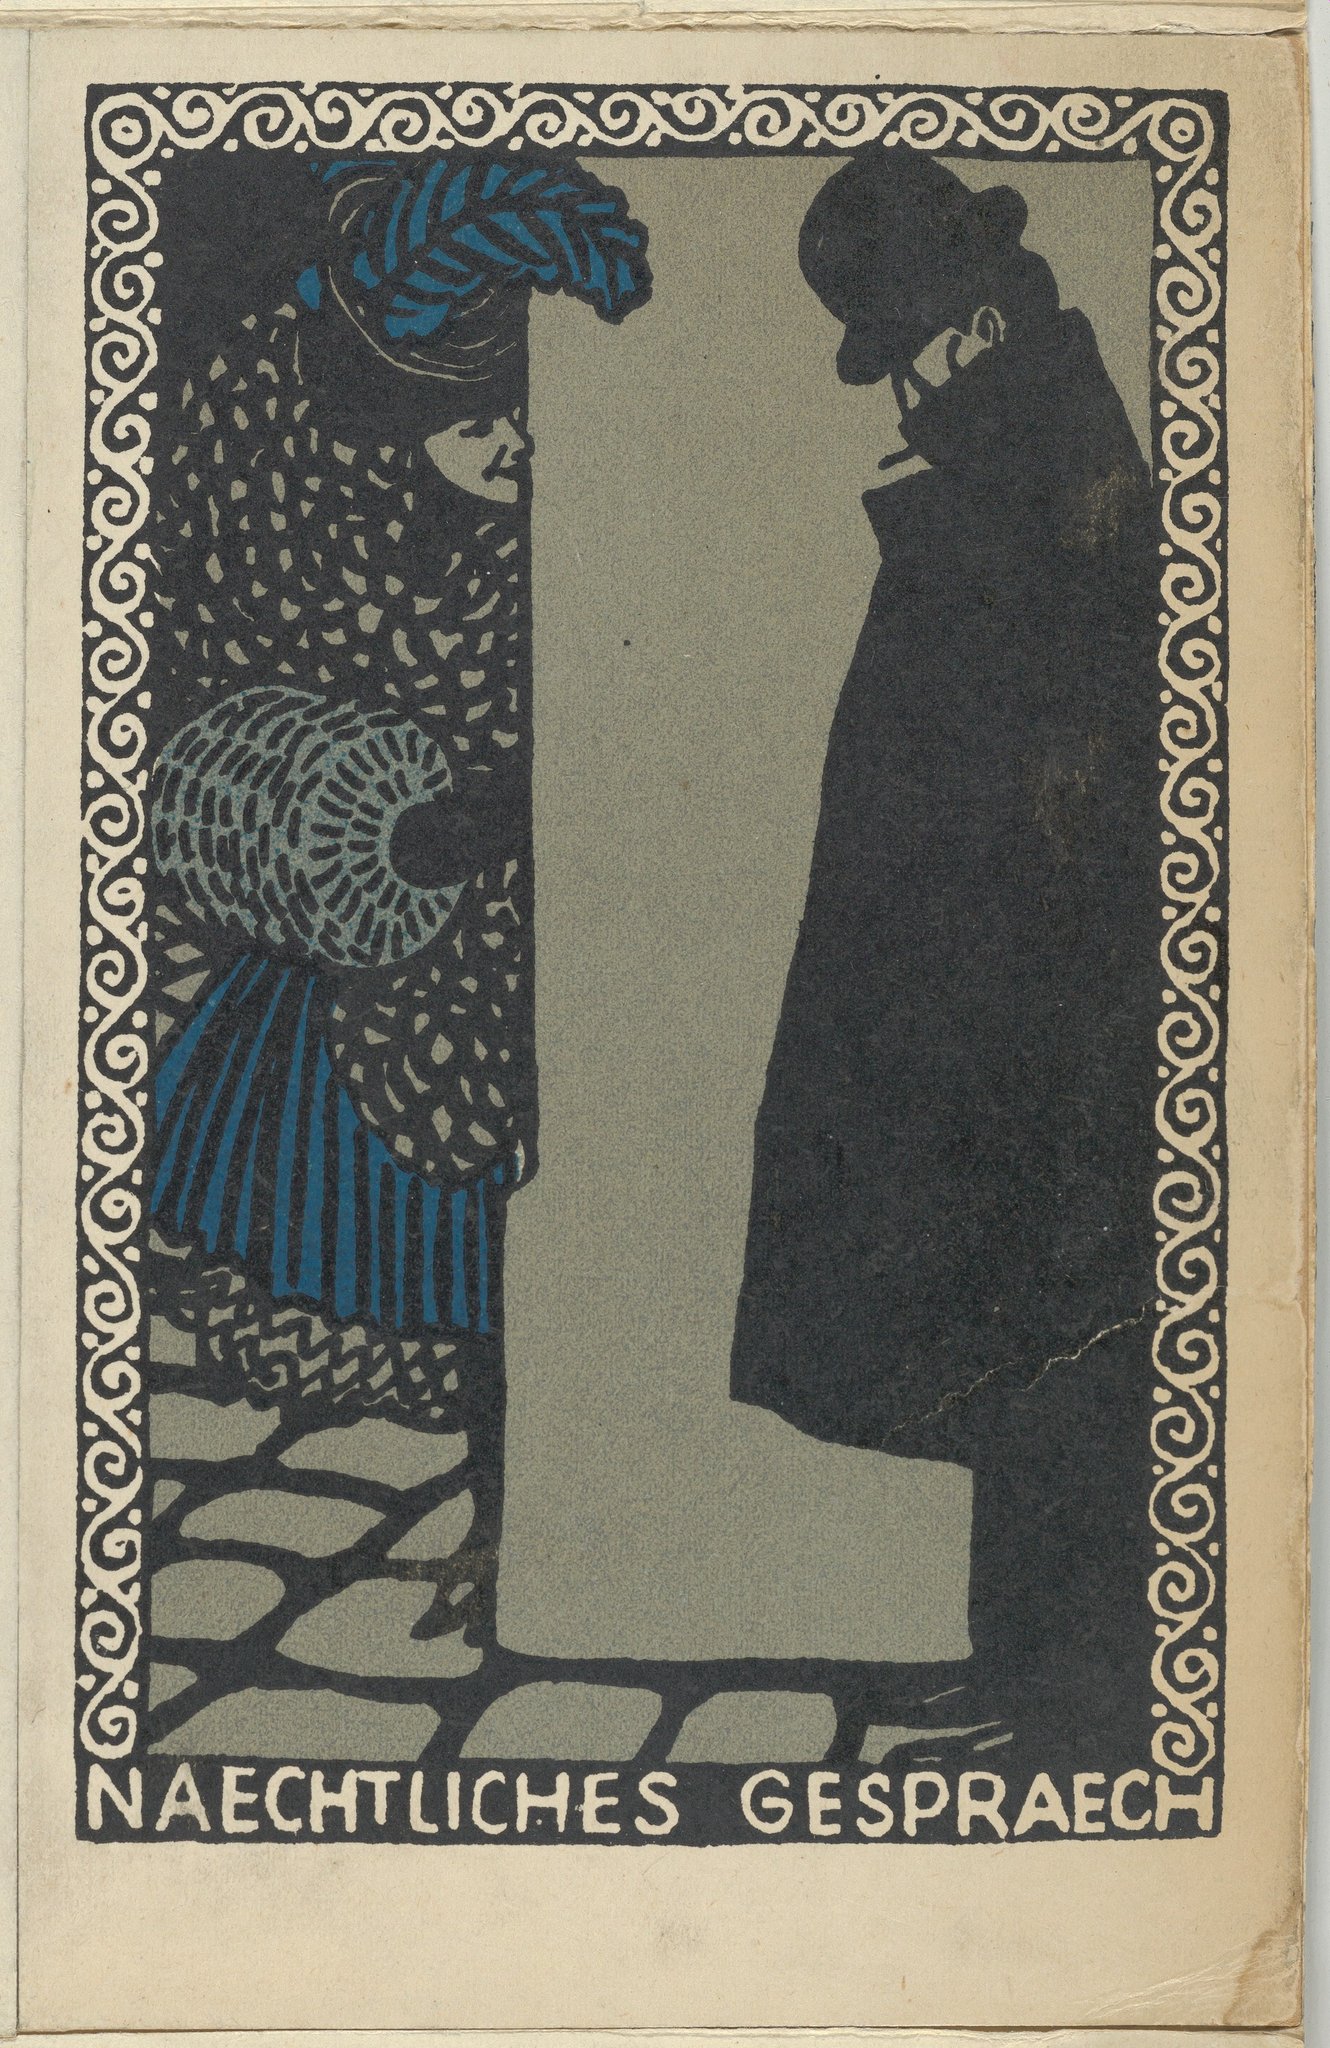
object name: print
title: Nightly Conversations (Naechtliches Gespraech)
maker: moriz jung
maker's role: artist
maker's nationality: austrian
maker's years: 1885-1915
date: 1907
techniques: lithograph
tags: men,women